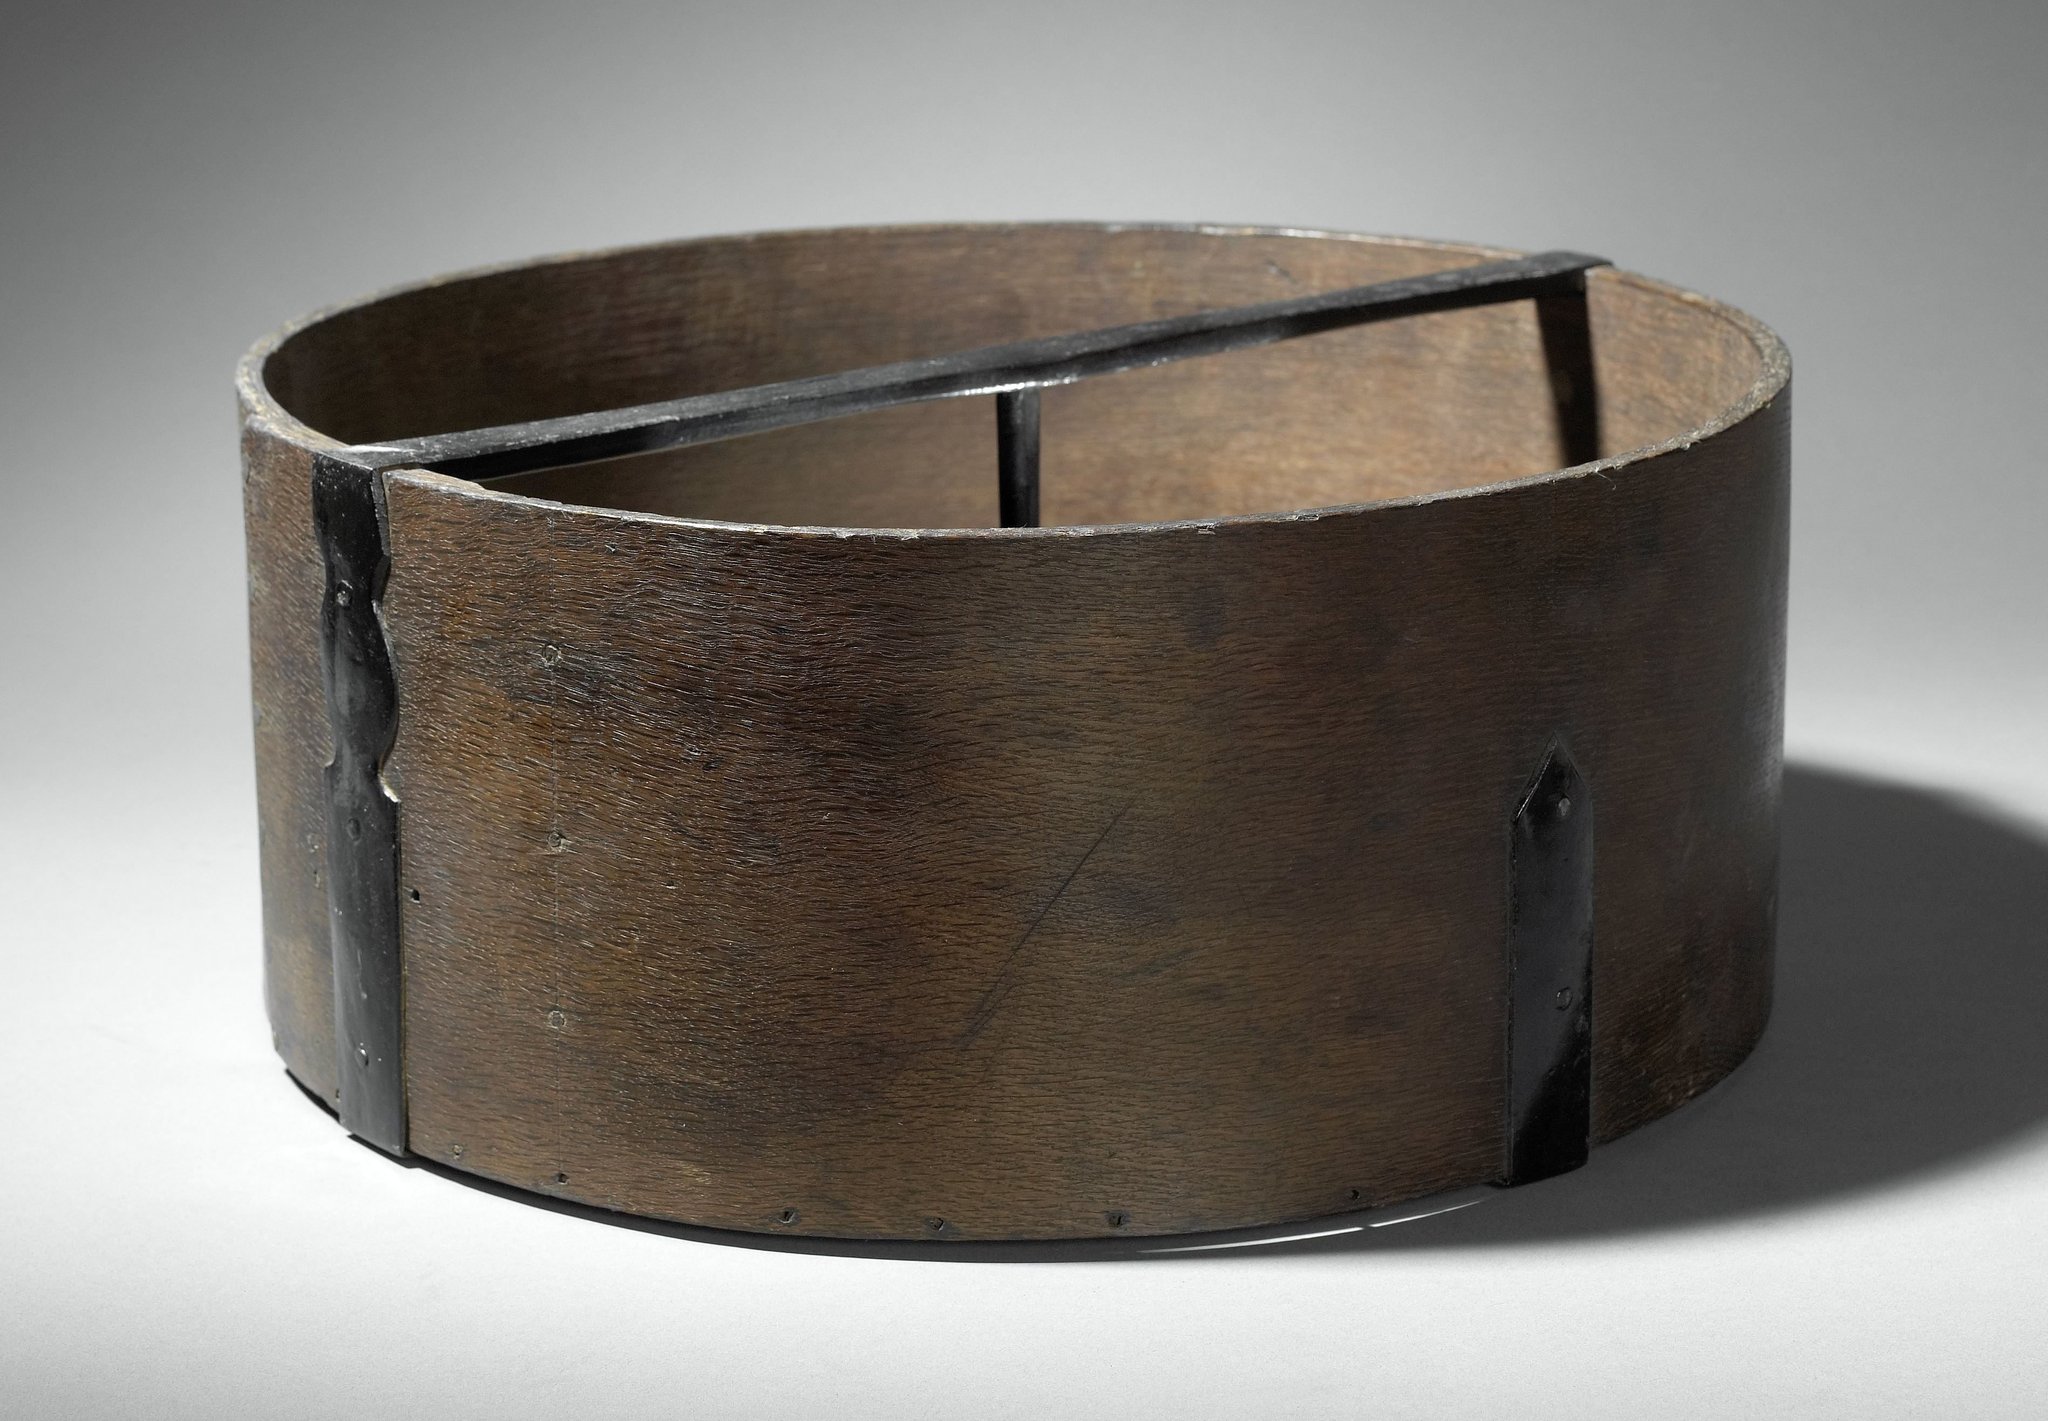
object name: inhoudsmaat droge waren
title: 1/2 Schepel uit Enkhuizen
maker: Anonymous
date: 1800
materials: iron, wood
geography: enkhuizen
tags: enkhuizen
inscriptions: number: ‘38’, title: ‘Enkhuyzen 1/2 Schepel, zijnde 1/4 van een zak’, title: ‘d'Enkhuyzen 1/2 Boisseau’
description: Spanen en ijzeren inhoudsmaat voor droge waren met brug en stijl van 1/2 schepel, v.z.v. etiketten.